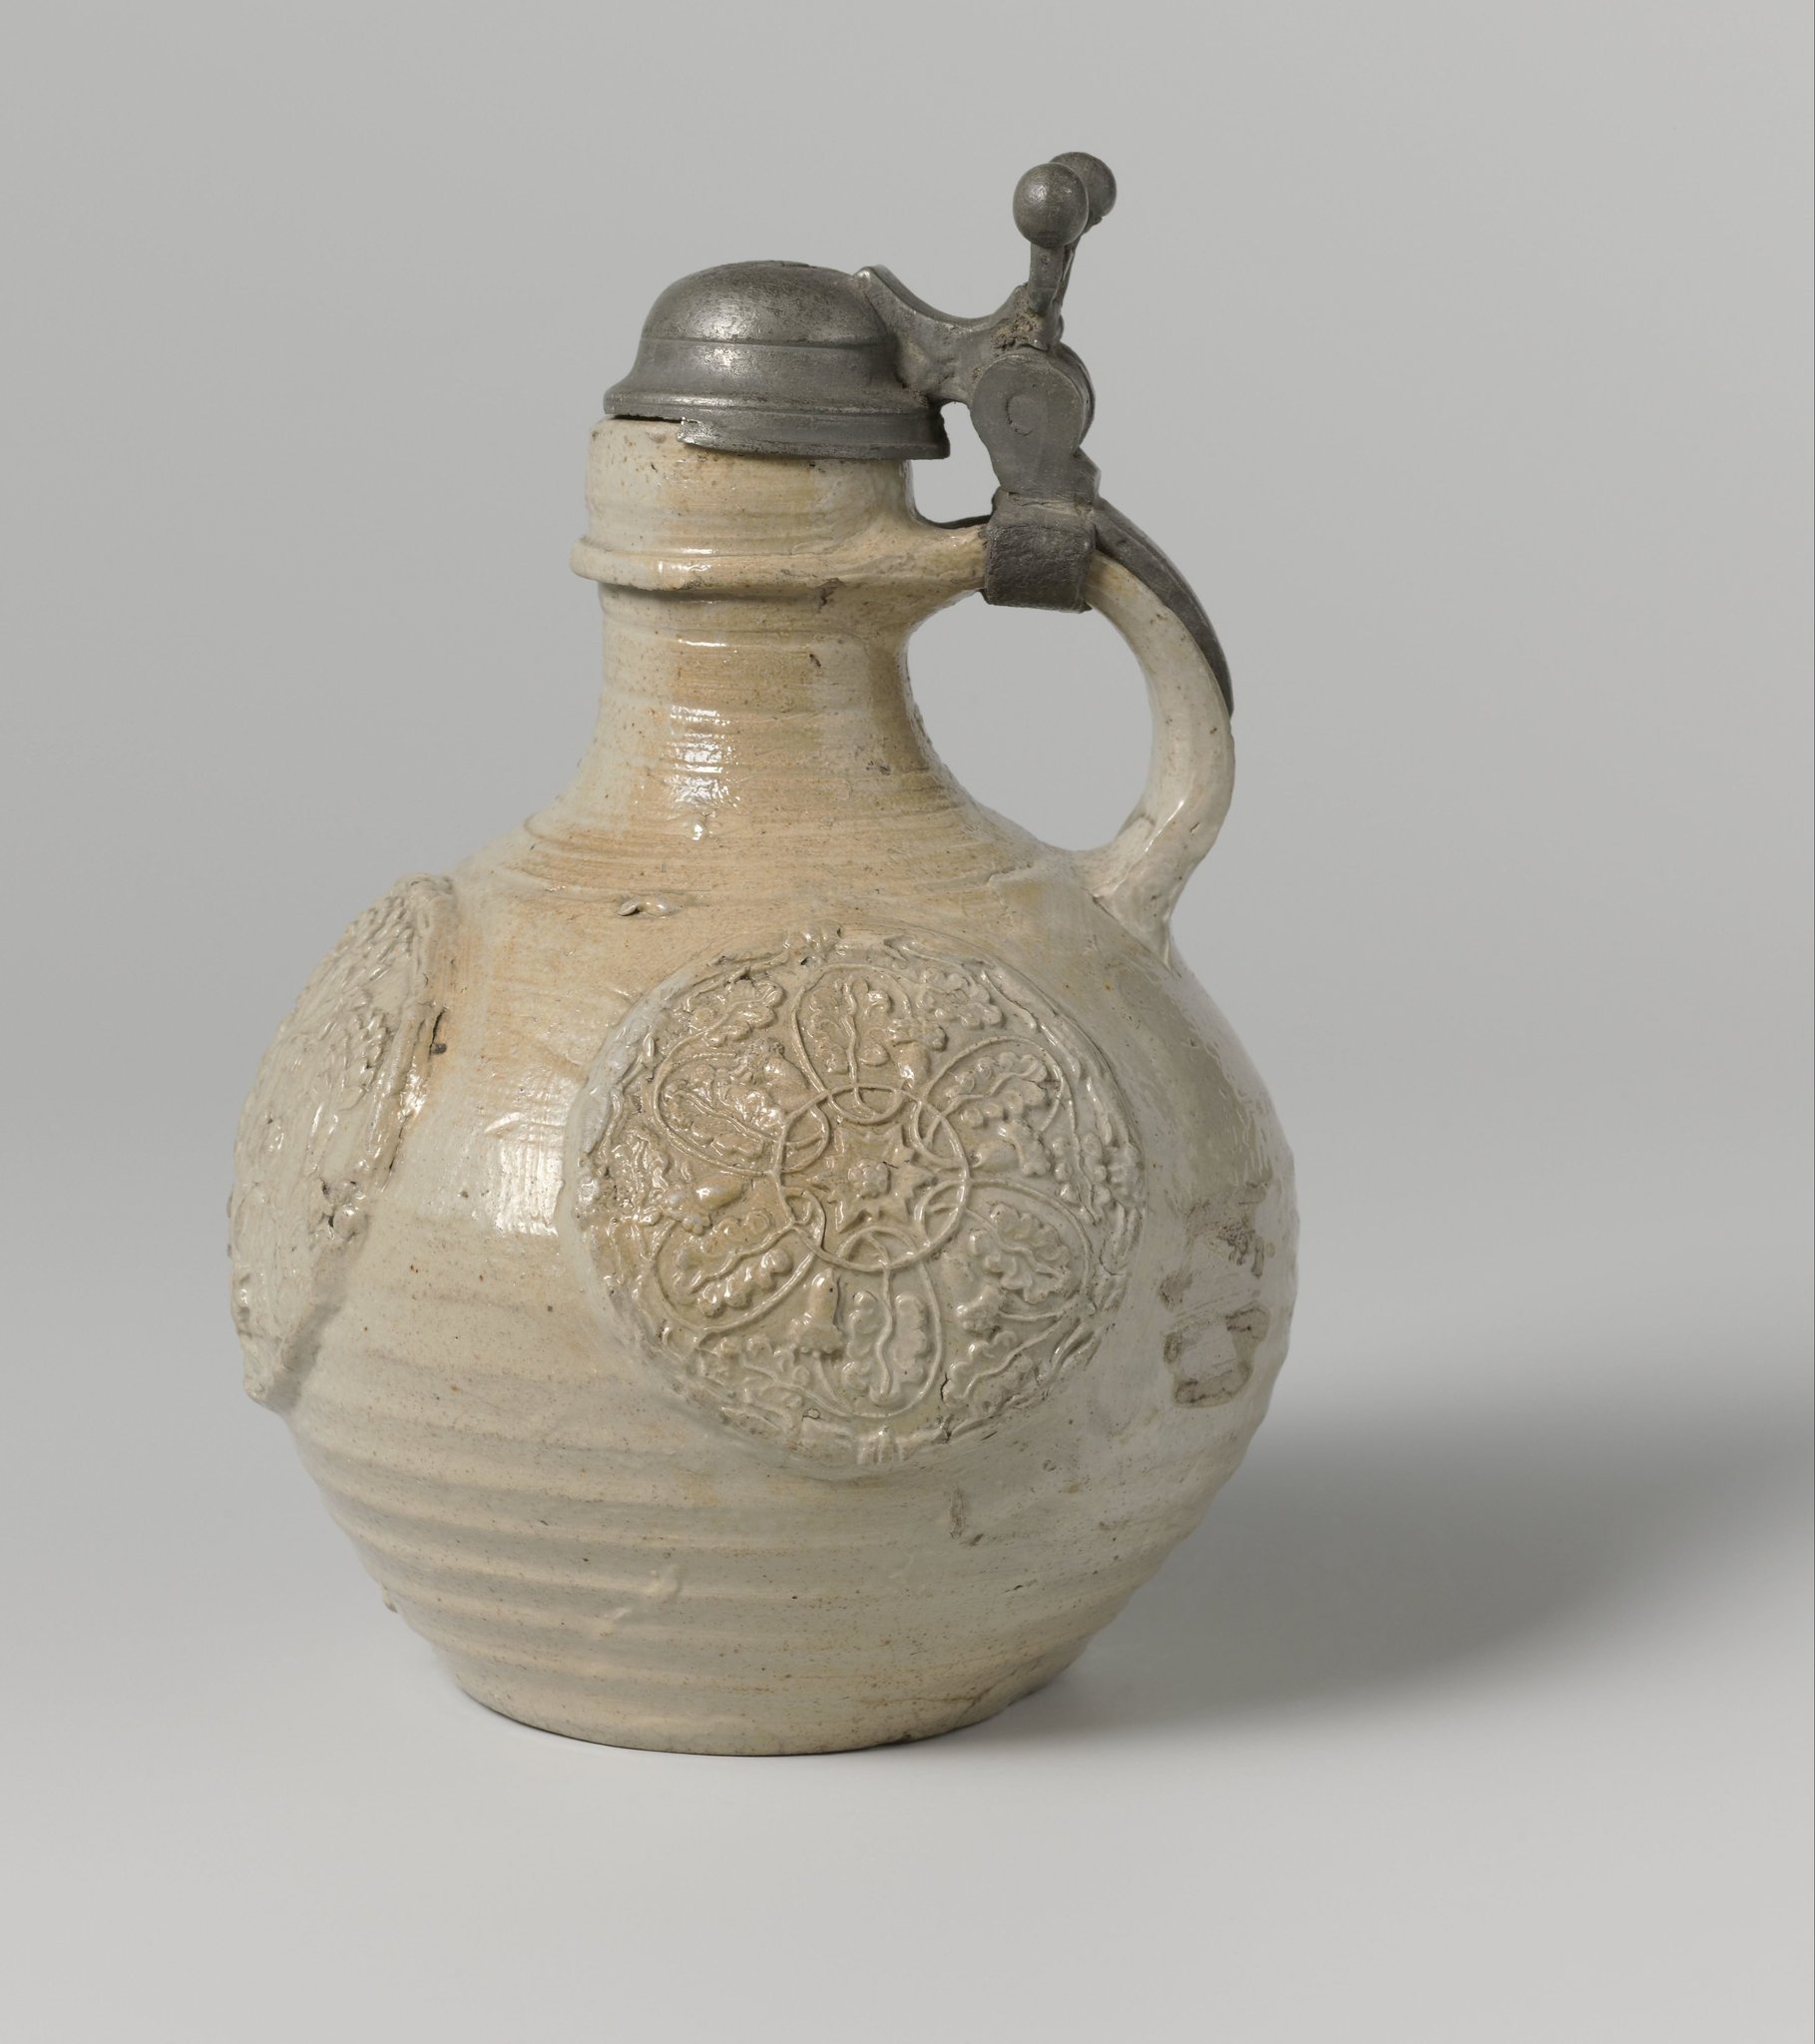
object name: jug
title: Jug with the fall of man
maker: Anonymous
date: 1560-1580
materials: glaze, stoneware, tin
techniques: firing, forming, relief, turning, vitrification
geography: siegburg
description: Kruik van steengoed op standvlak met een eivormig lichaam en smalle nek. Het C-vormige oor is bevestigd aan de nek en de schouder. Profiel op de nek. Het lichaam is bedekt met draairingen. Op de buik in reliëf drie gedrukte en opgelegde medaillons. In het midden een voorstelling van de Zondeval, met Adam, Eva en God in het Paradijs. Aan weerszijden hiervan een medaillon met gestileerde eikenranken. Bevestigd aan het oor een tinnen montuur met deksel. Op de binnenzijde van de deksel gemerkt met een bloem. Siegburg.